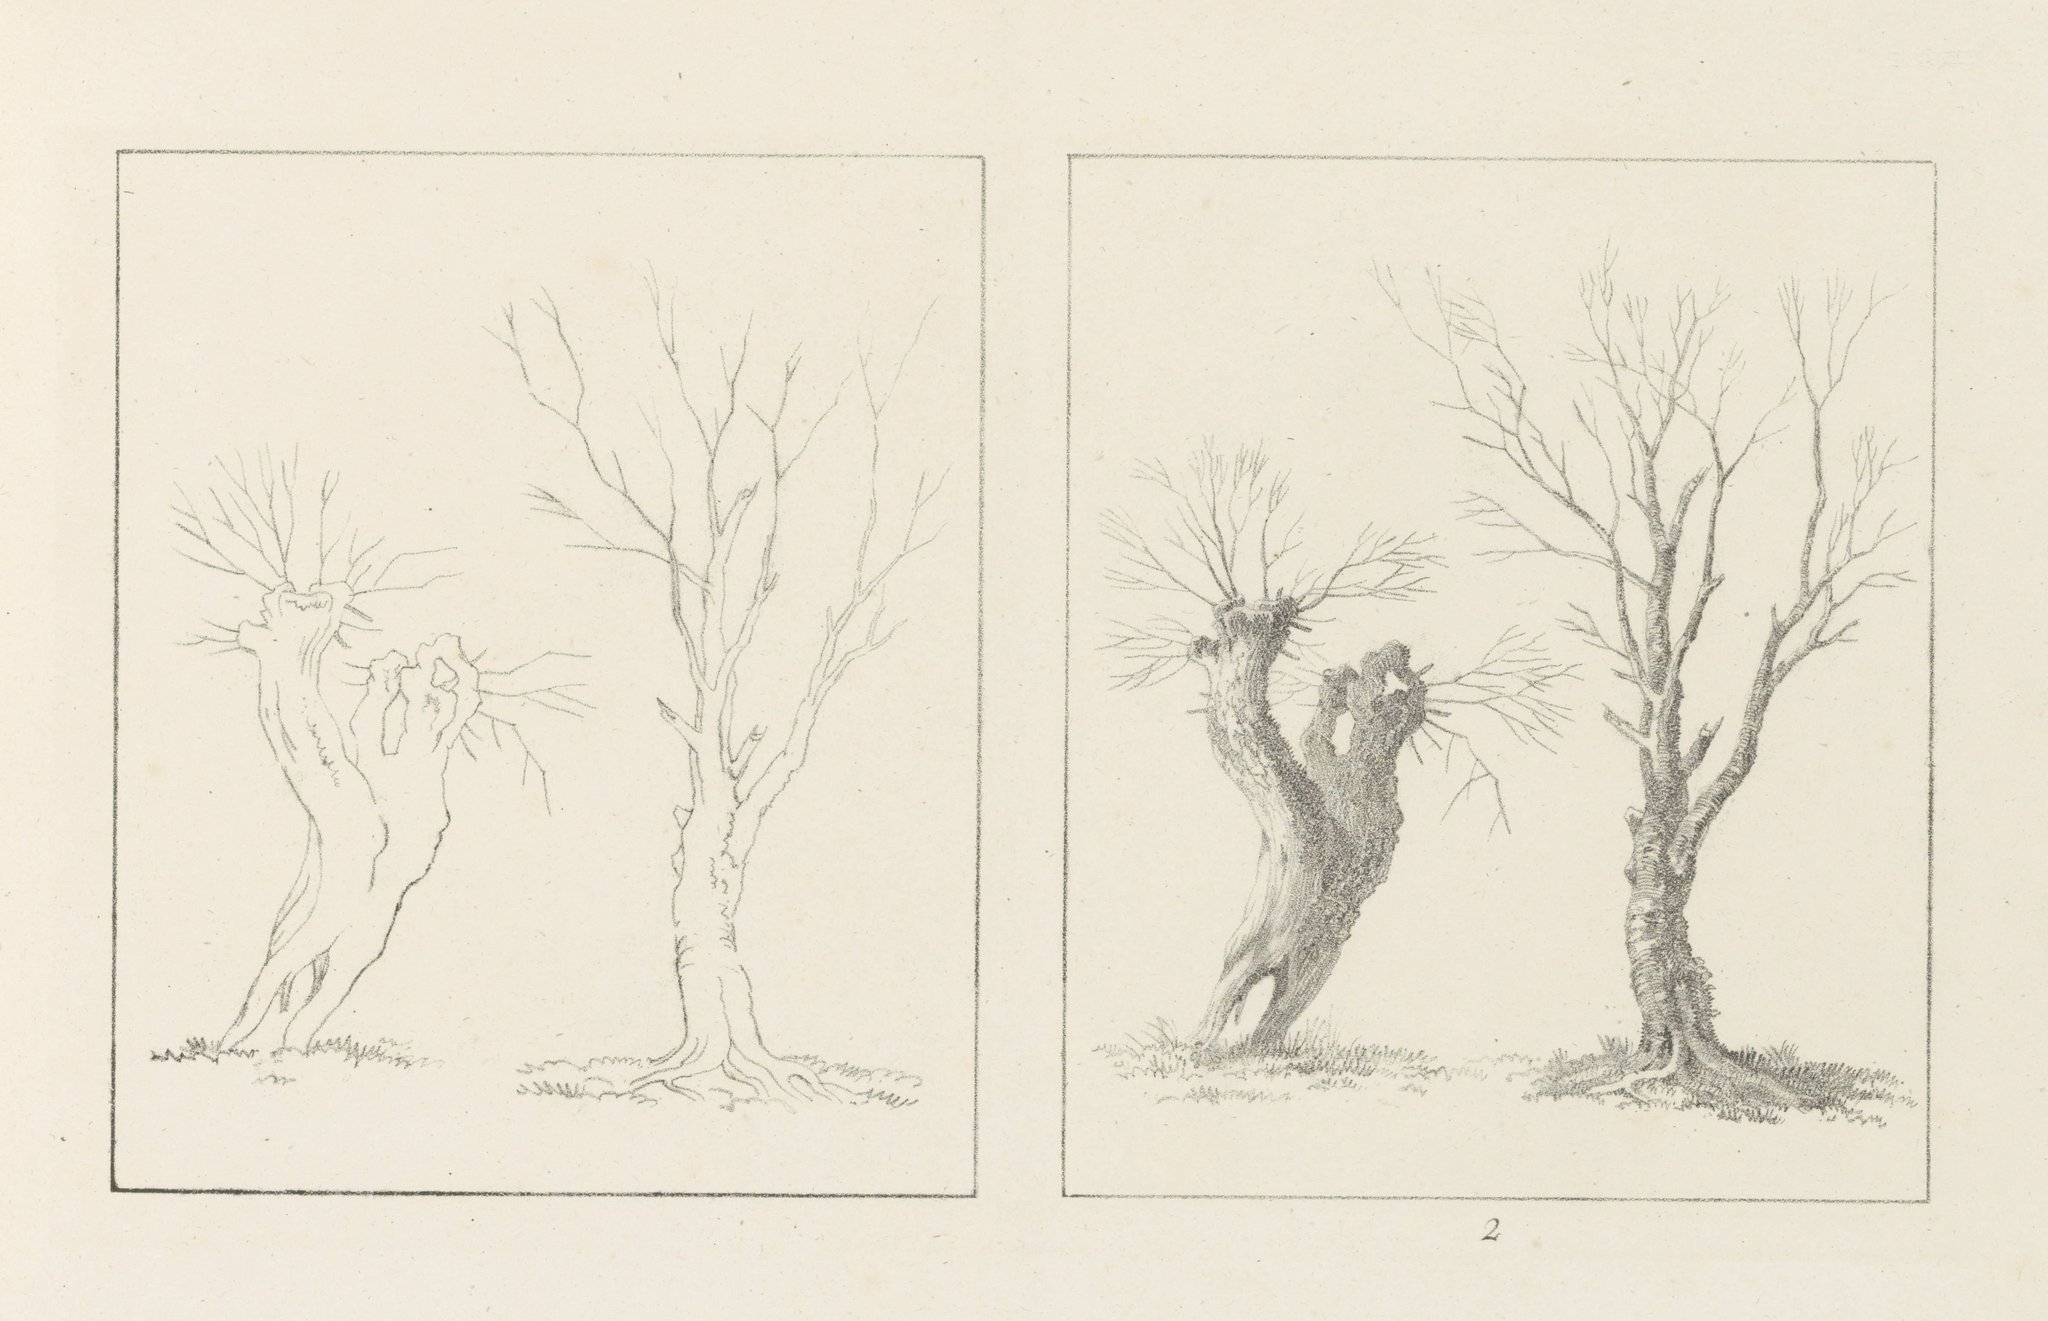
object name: print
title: Albumblad met twee voorstellingen van kale bomen; links het ontwerp, rechts de uitvoering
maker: max josef wagenbauer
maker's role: print maker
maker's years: 1774-1829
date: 1816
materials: paper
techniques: lithograph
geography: munich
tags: trees, the graphic arts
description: Albumblad met twee voorstellingen van kale bomen; links het ontwerp, rechts de uitvoering. Maakt deel uit van een album met 18 bladen met studies van bomen.